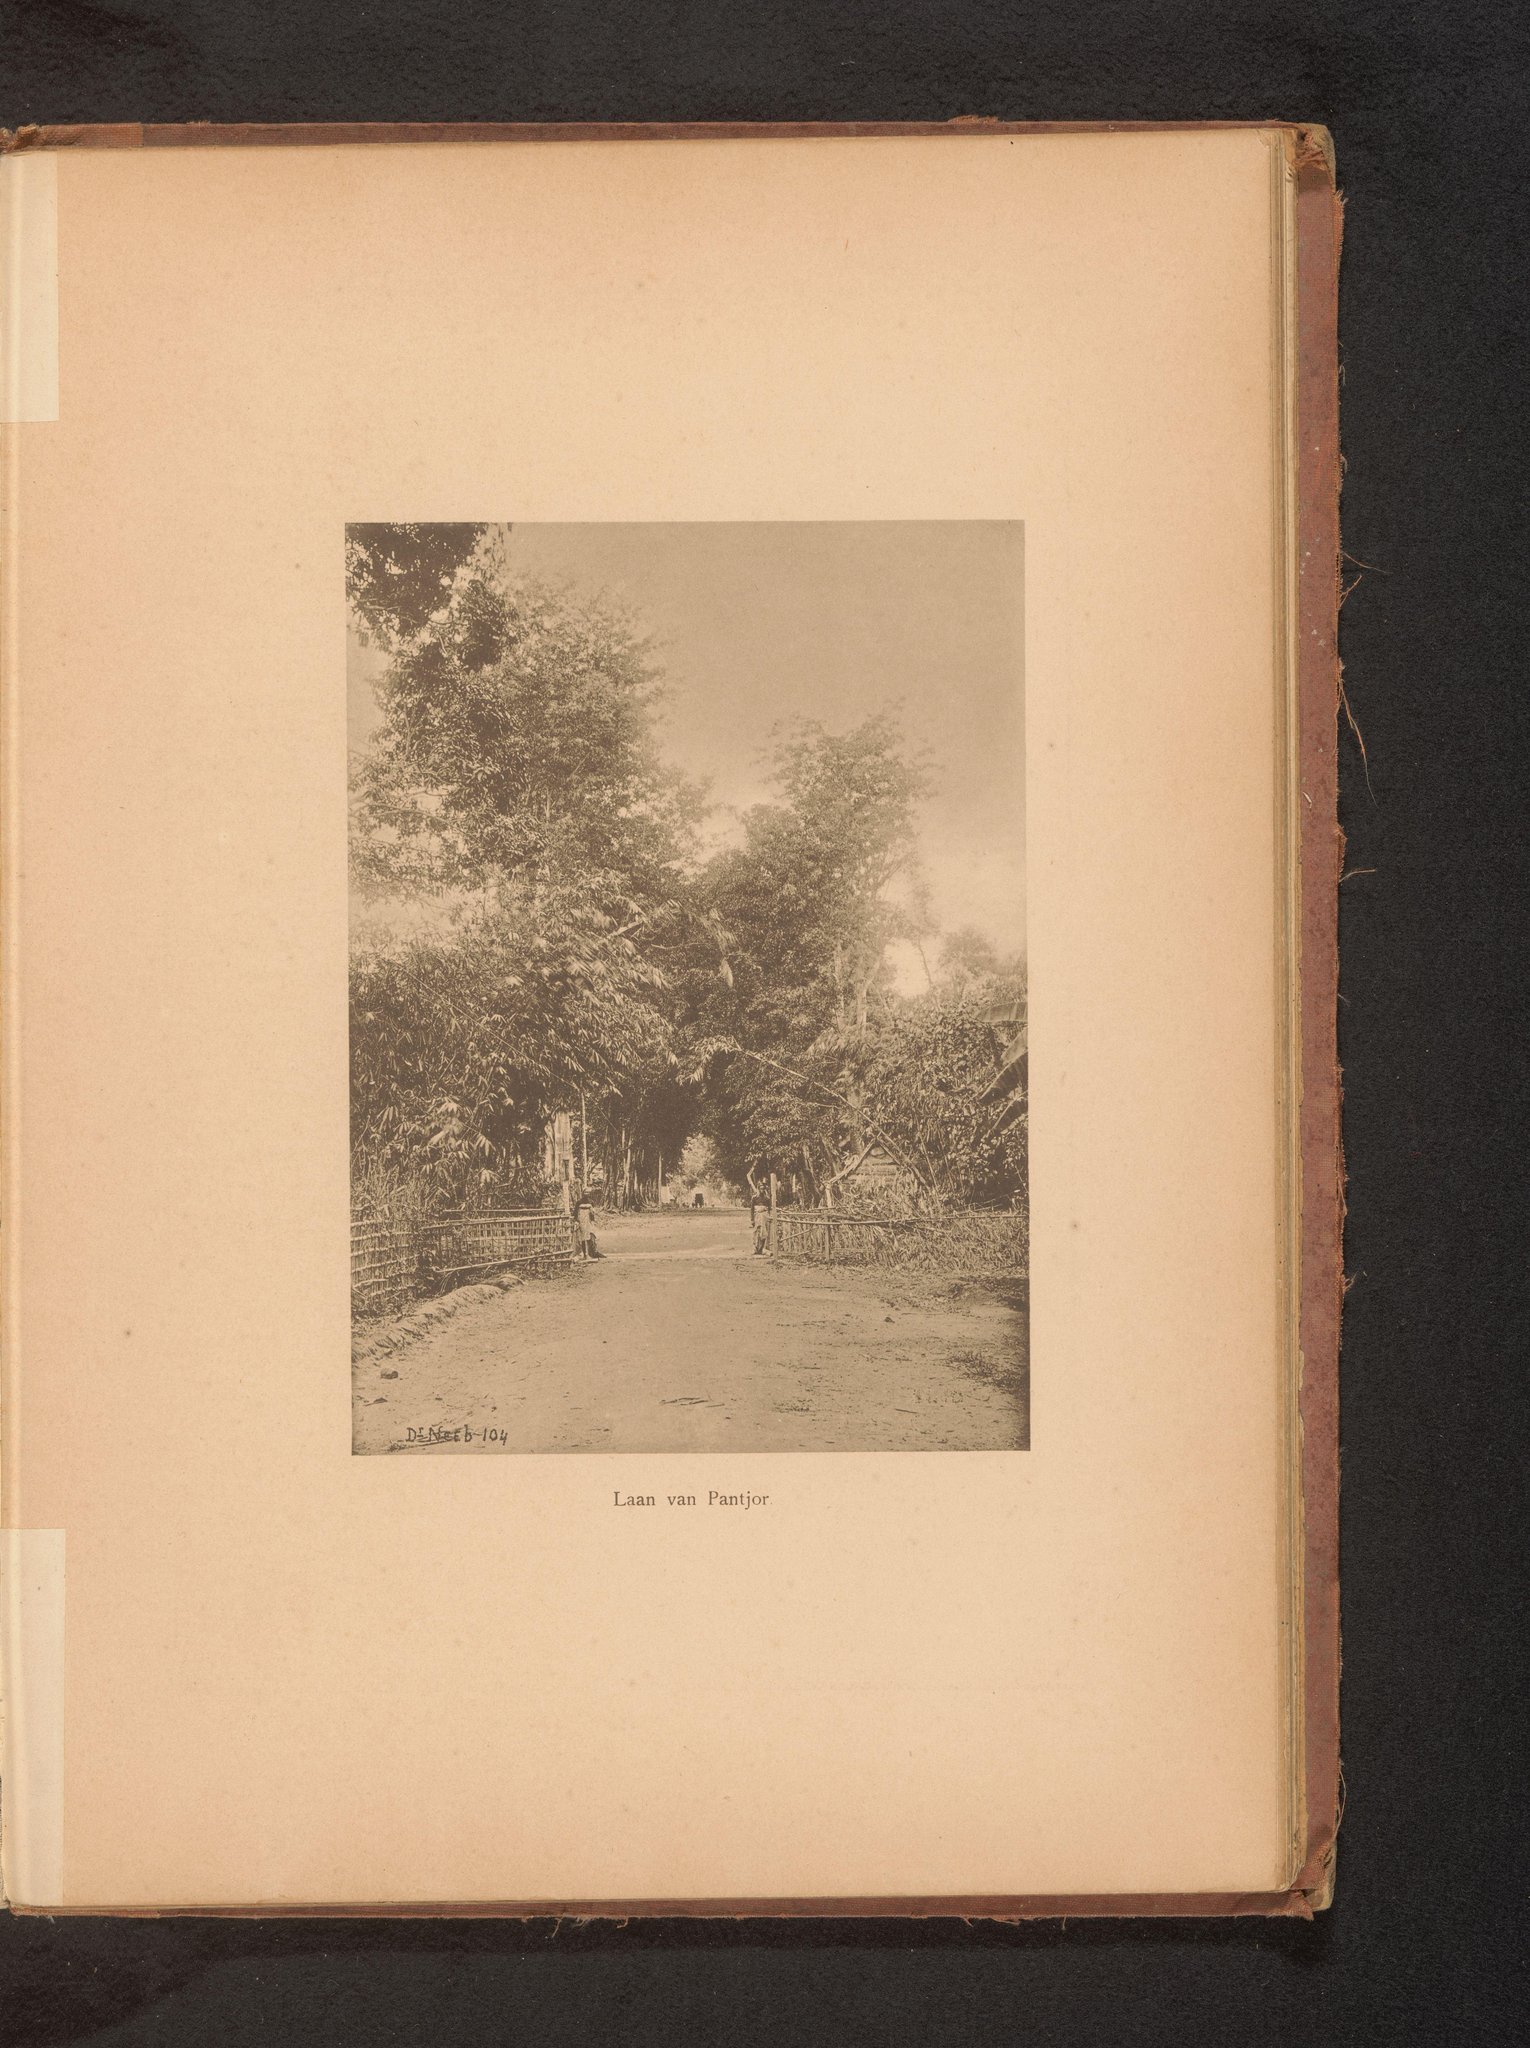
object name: page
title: Gezicht op een weg in een bebost gebied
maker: christiaan johan neeb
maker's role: arts, fotograaf, officier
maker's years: 1860-1925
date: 1892-1897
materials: paper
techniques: photograph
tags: trees, road, path, indonesia